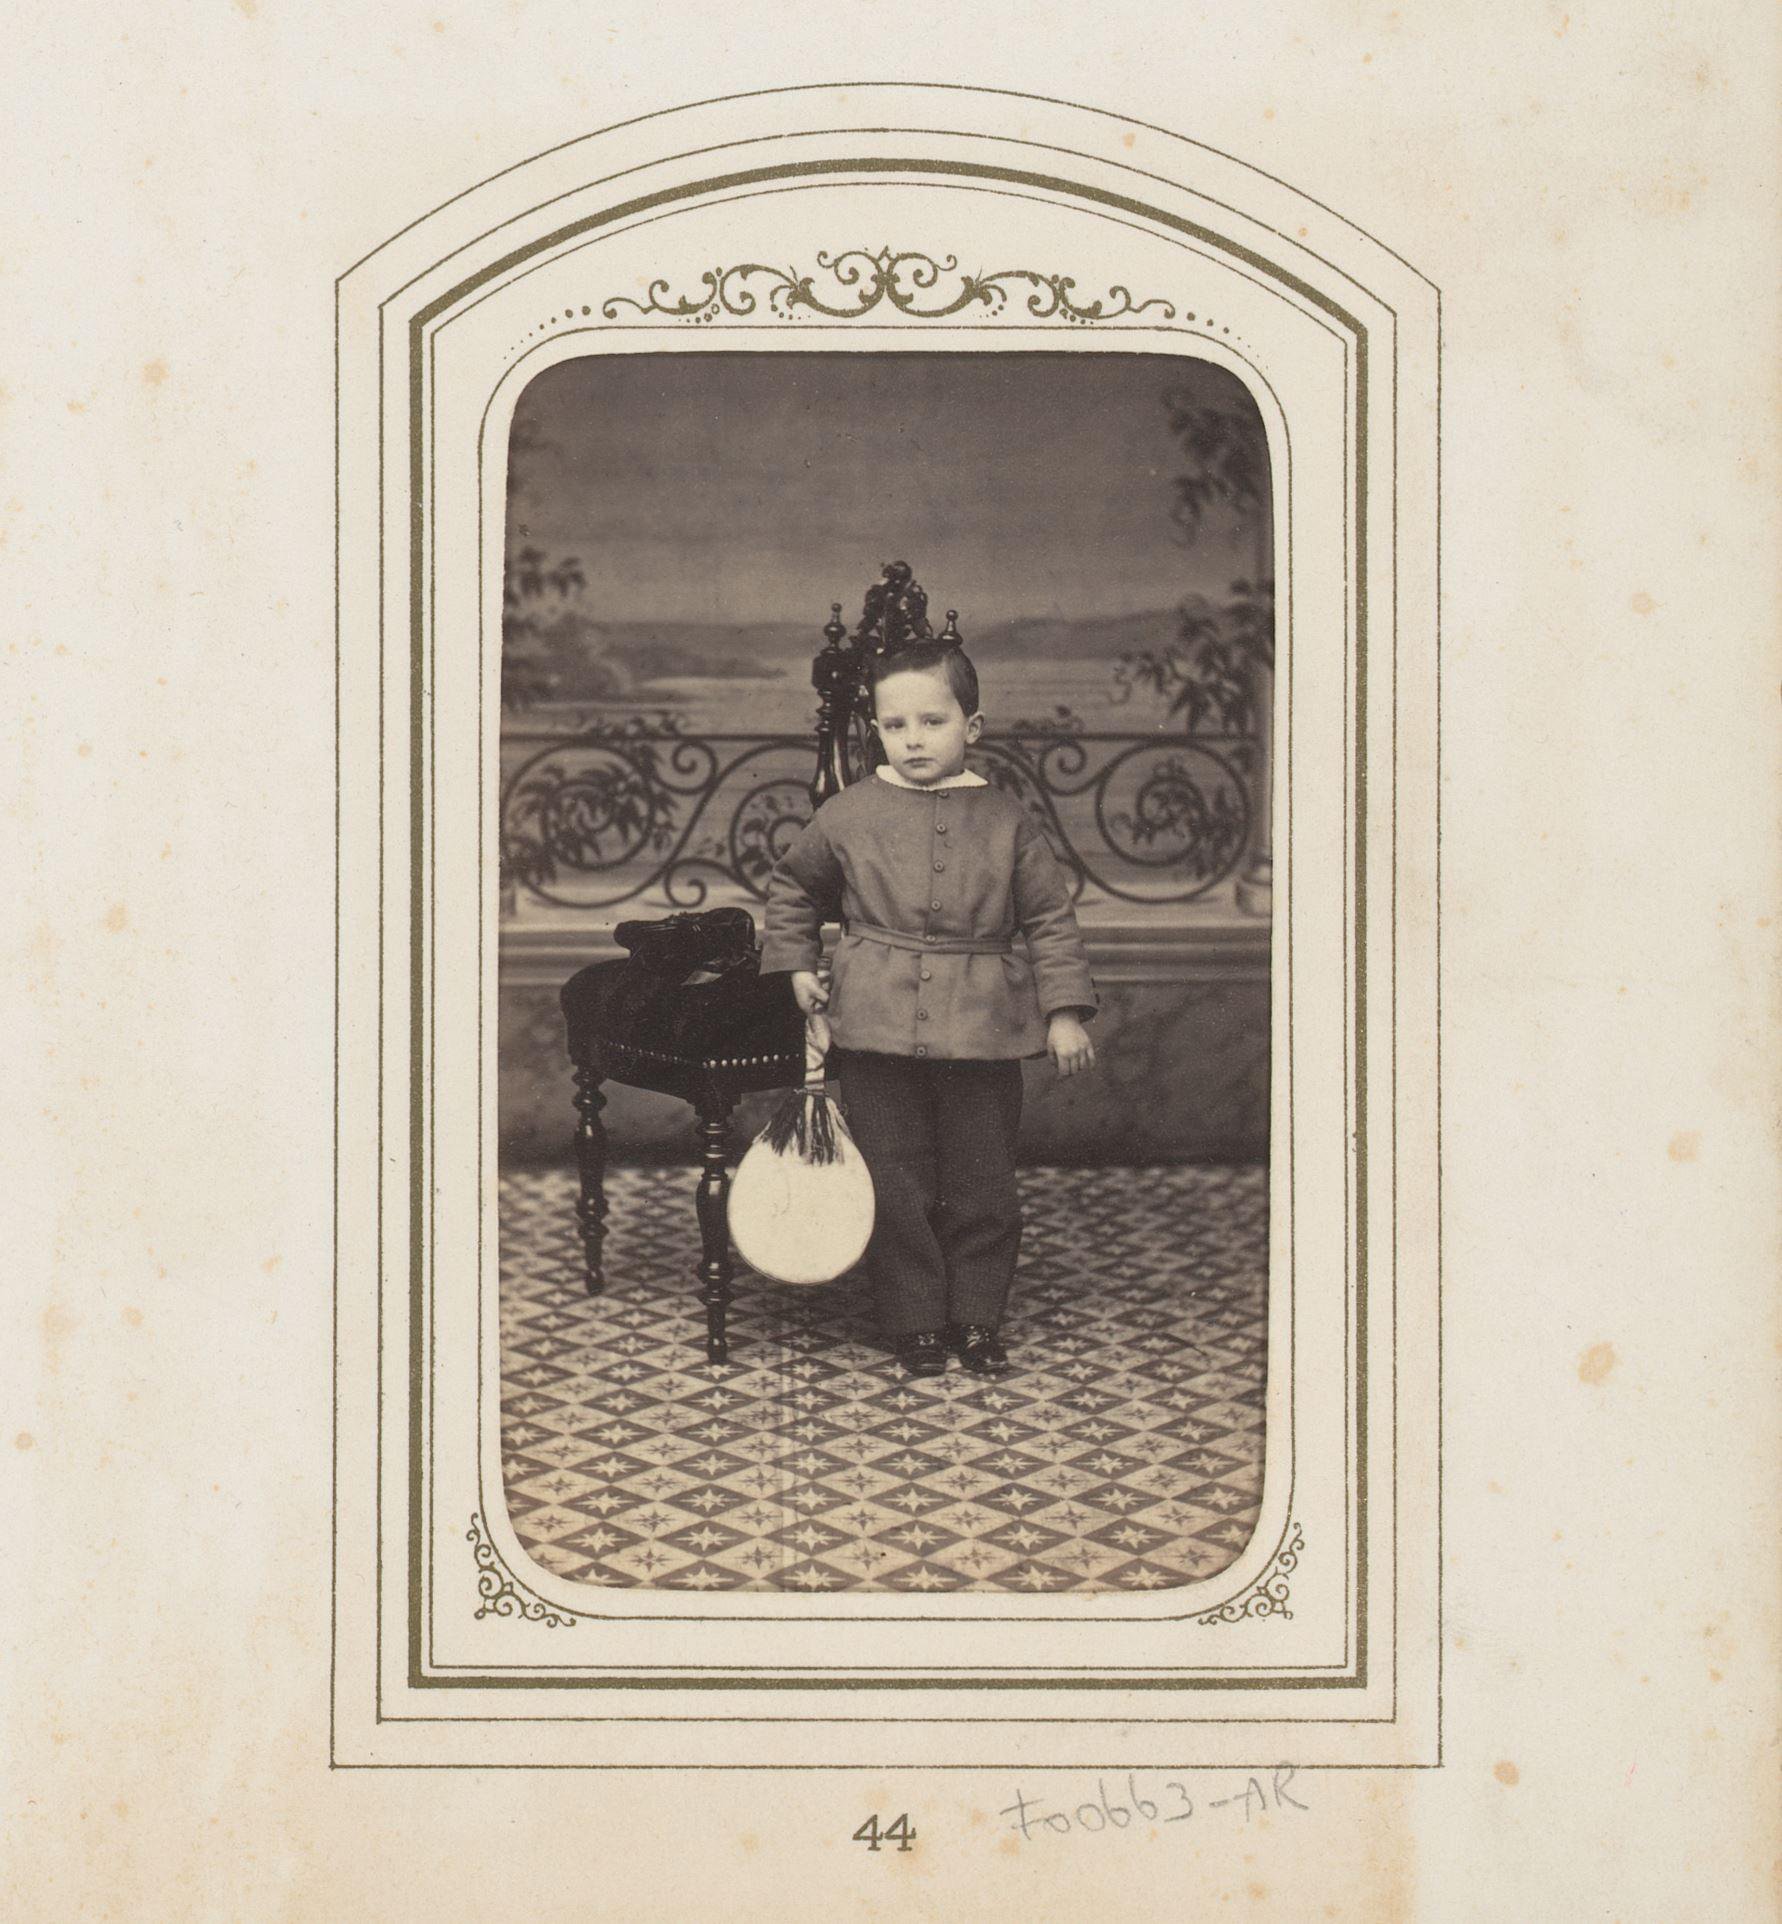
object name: album leaf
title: Portret van een staande jongen met tennisracket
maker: eduard fuchs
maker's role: painter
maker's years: 1832-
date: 1860-1870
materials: cardboard, photographic support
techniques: albumen print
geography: leeuwarden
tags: boy (child between toddler and youth)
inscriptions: number: ‘44’, inscription: ‘Photographie/ E. Fuchs/ Leeuwarden’